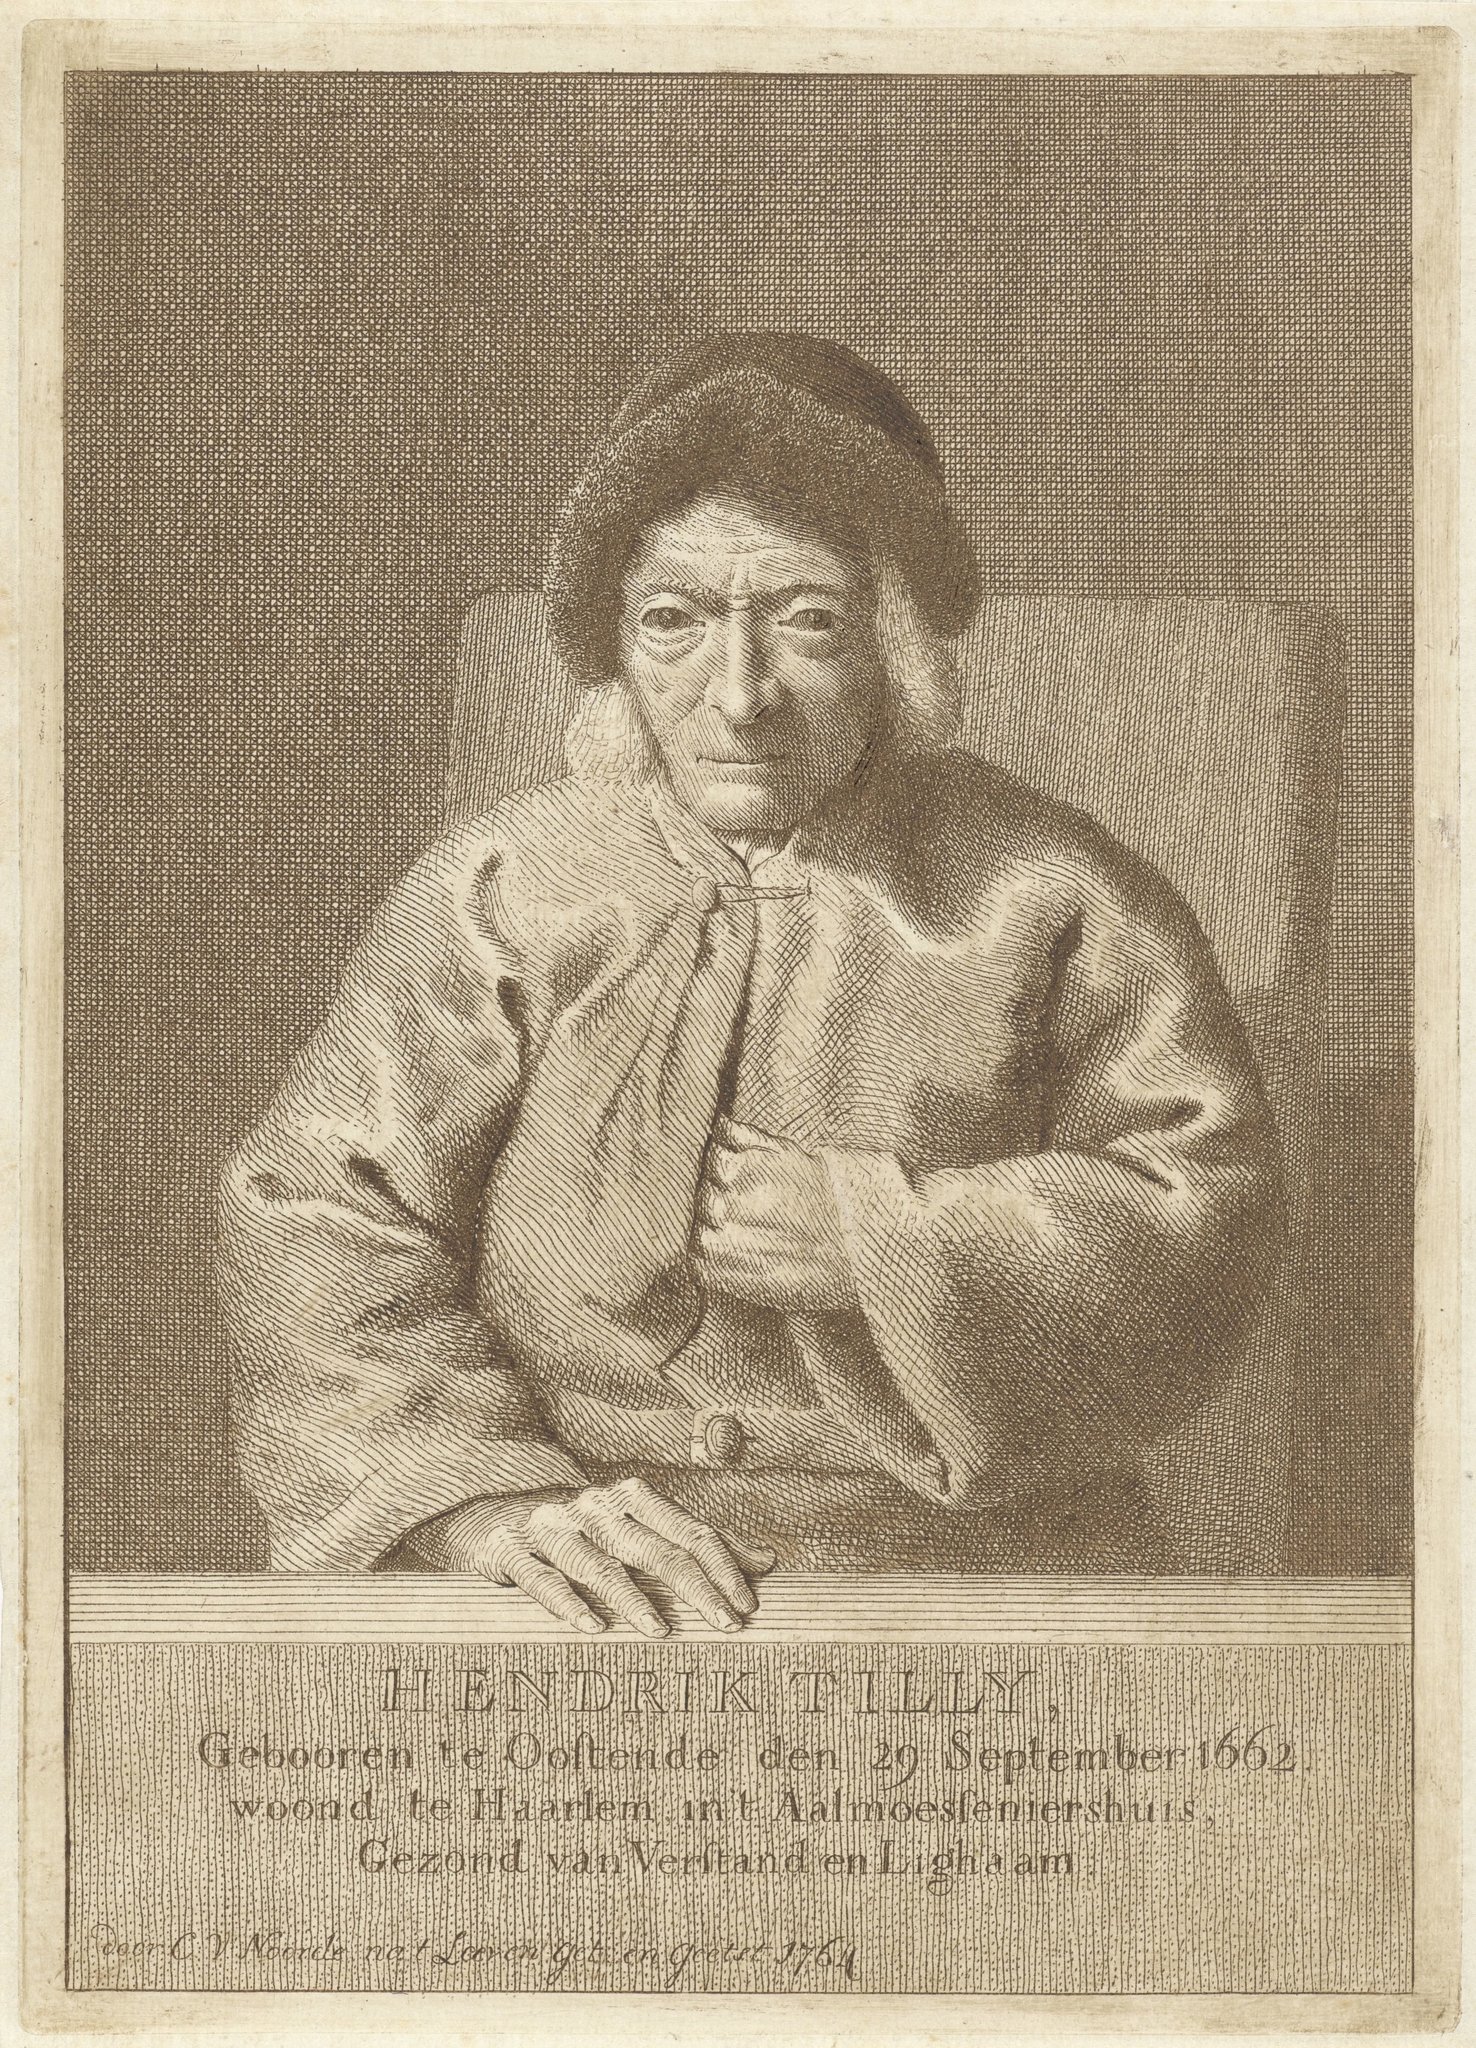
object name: print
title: Portret van Hendrik Tilly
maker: cornelis van noorde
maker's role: draughtsman, print maker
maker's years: 1731-1795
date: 1764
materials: paper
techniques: engraving, etching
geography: haarlem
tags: oostende, hendrik tilly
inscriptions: collector's mark: Lugt 240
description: Portret van Hendrik Tilly op 102-jarige leeftijd. Hij woonde in het Aalmoezeniershuis van Haarlem.